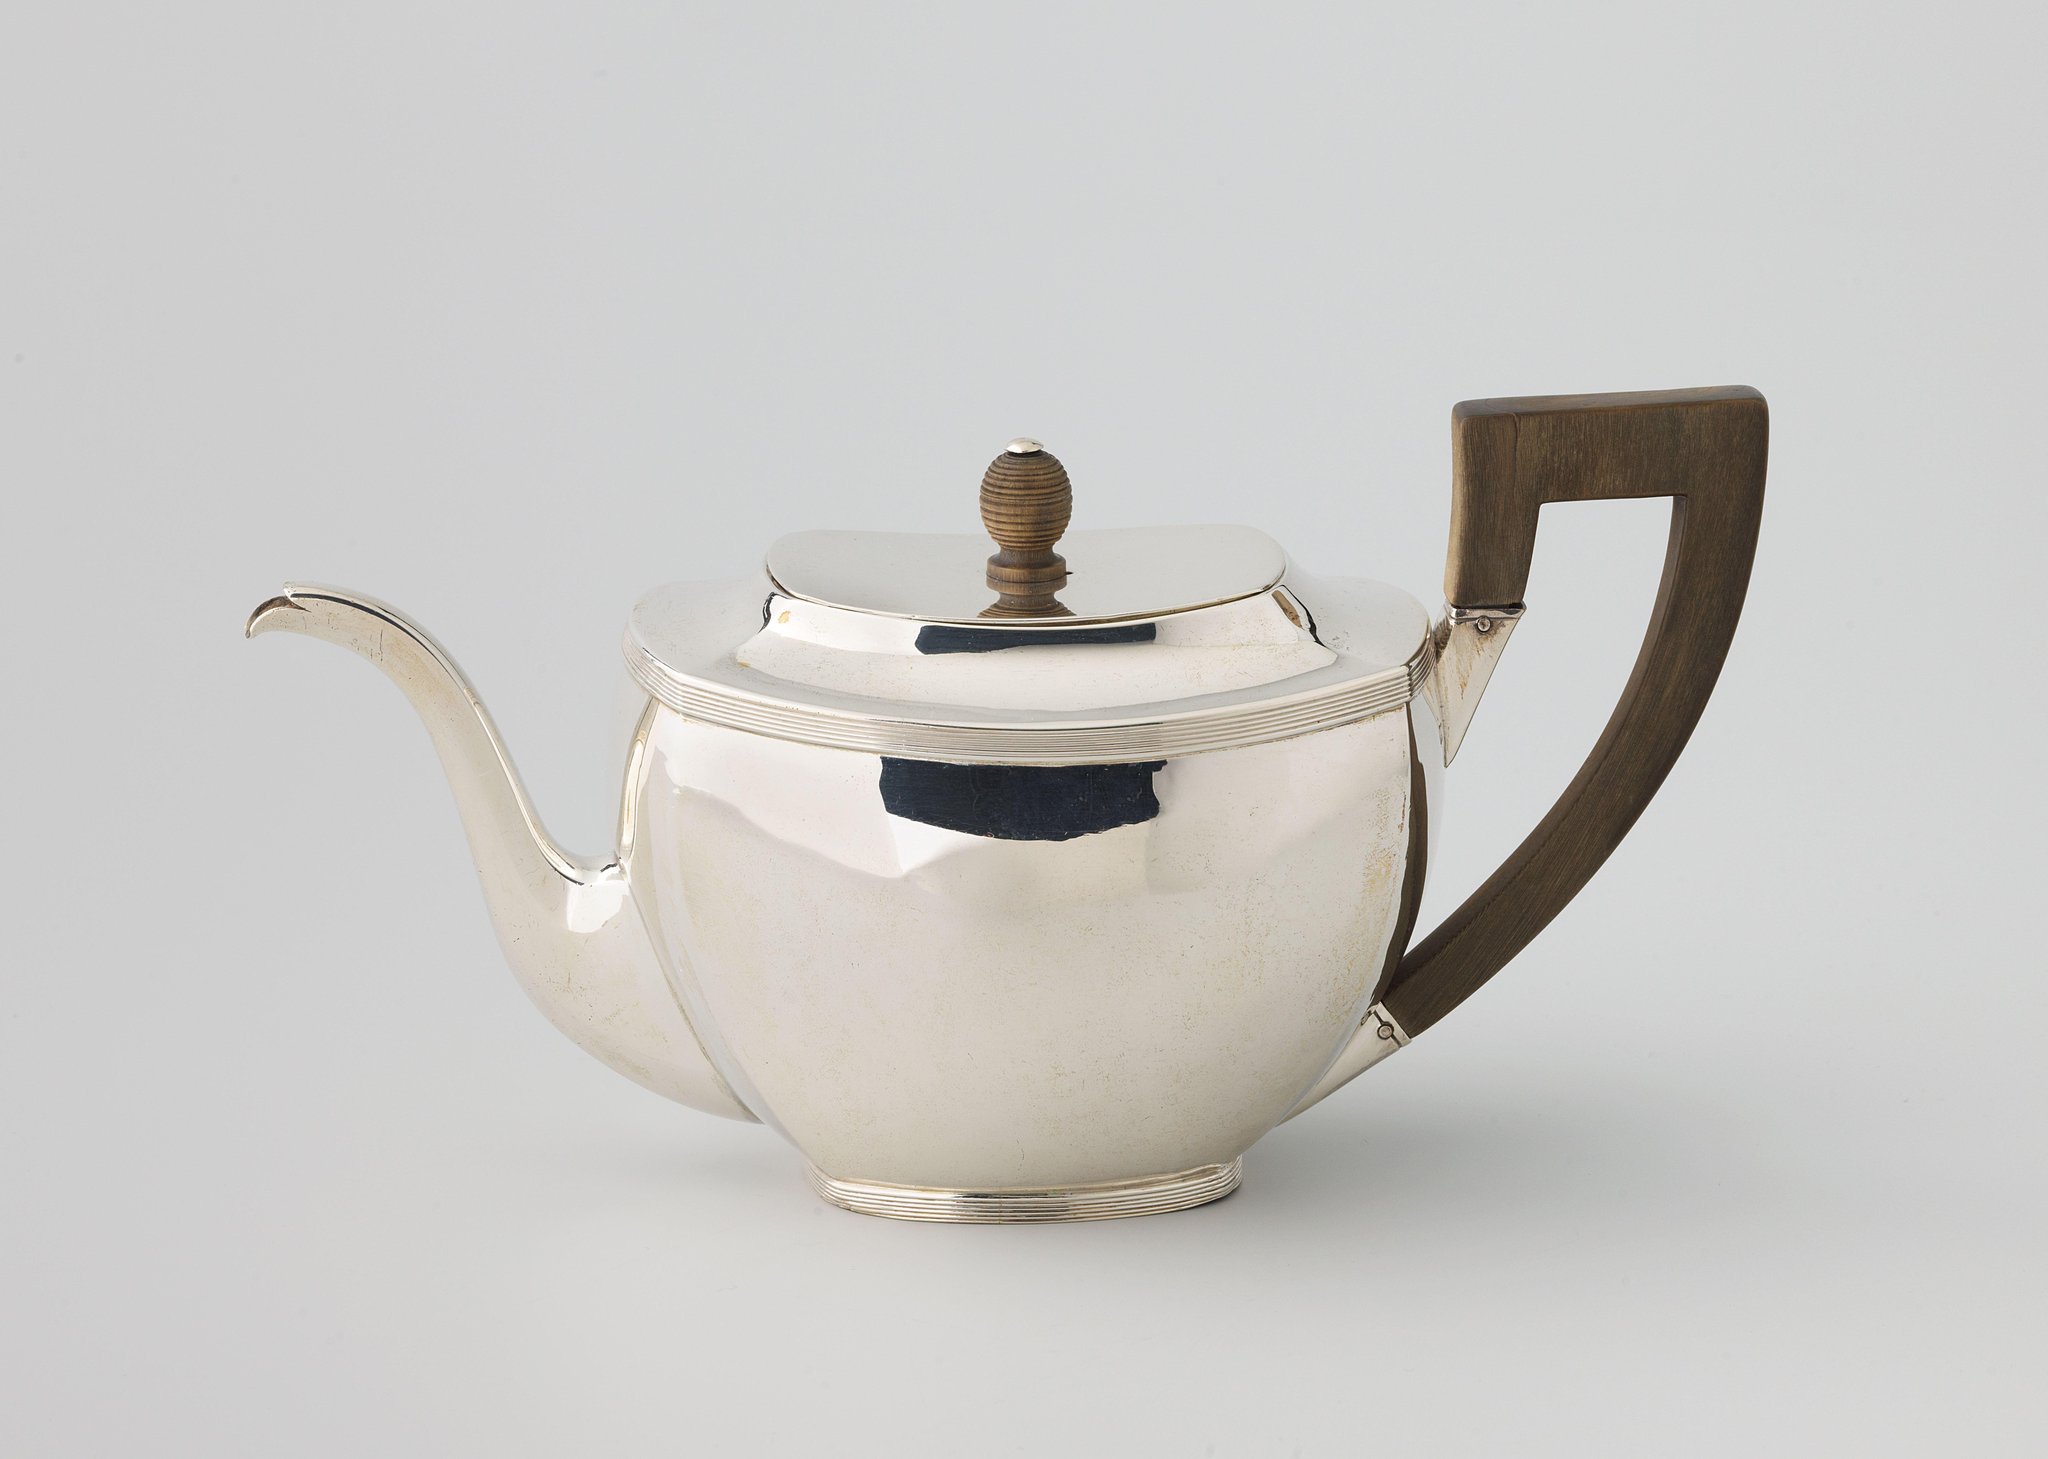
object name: teapot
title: Theepot, afgerond rechthoekig, met filetranden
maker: jean anthoine de haas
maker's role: silversmith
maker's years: 1753-1835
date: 1821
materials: wood, silver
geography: amsterdam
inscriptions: alloy mark, date letter: ‘M’, assay office mark, maker's mark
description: Matching teapot and caddy. Silver, ebony handle and knob of lid. Amsterdam, 1820 and 1821, by Jan Anthonis de Haas. Given by Mr and Mrs Jaffé-Pierson, 1978.